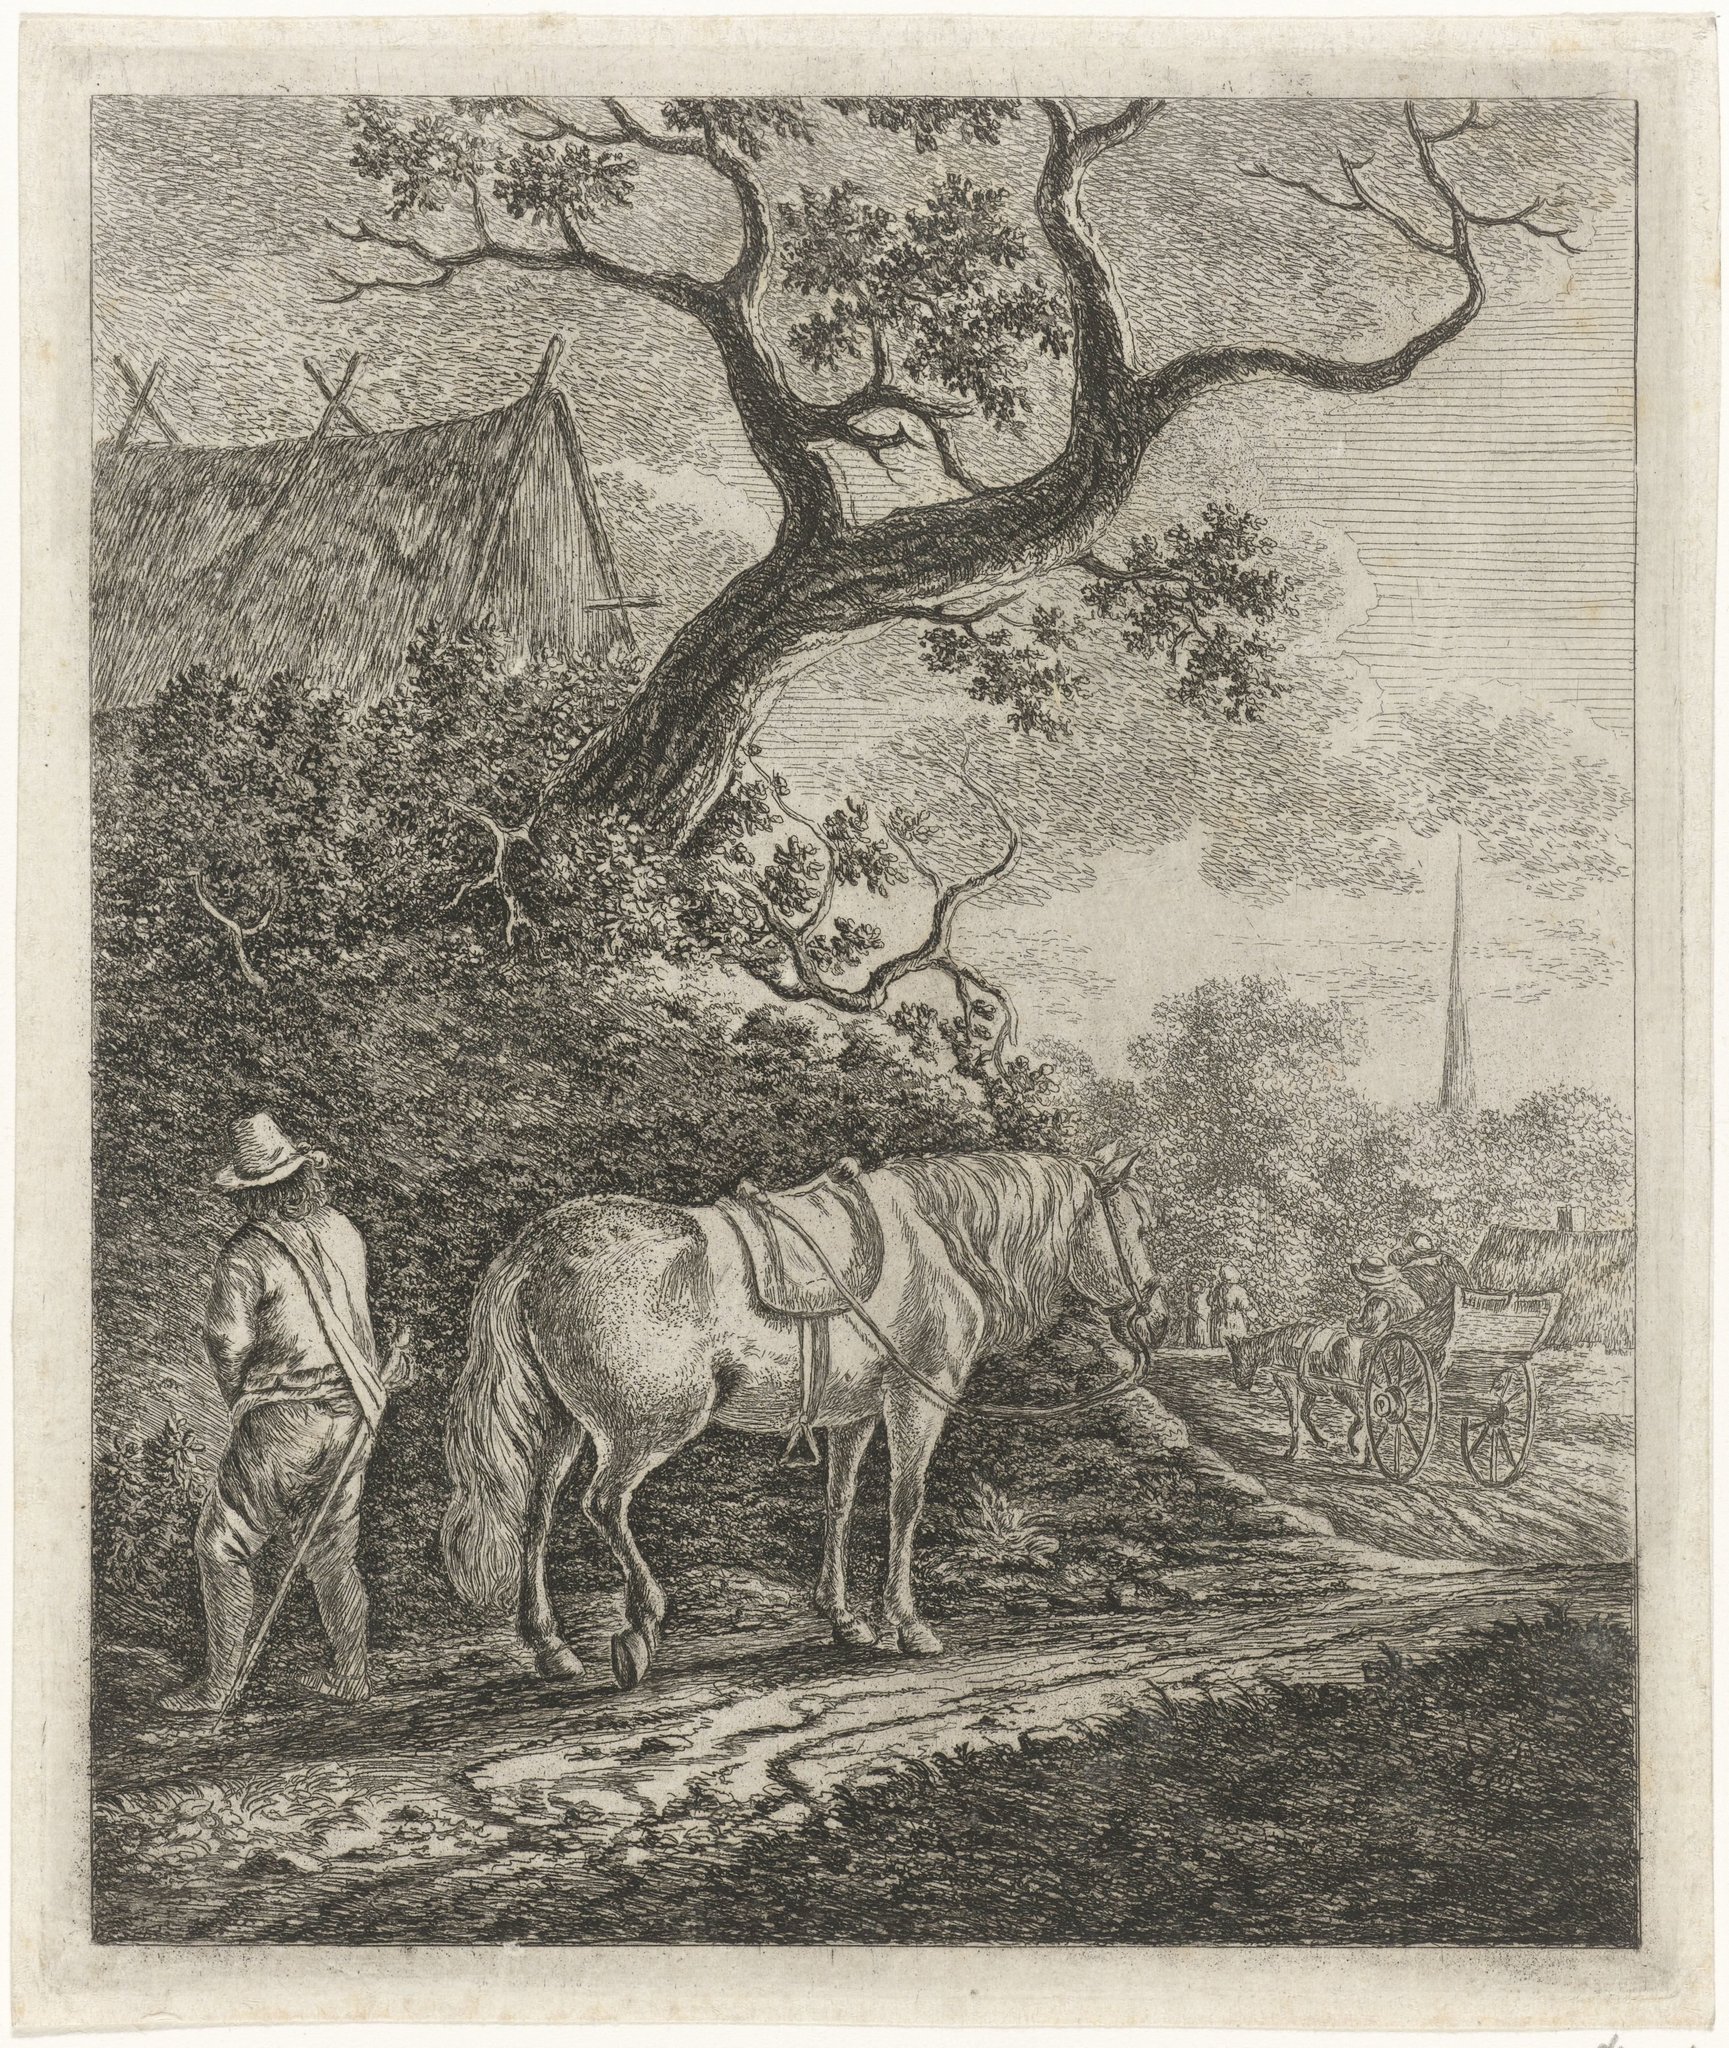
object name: print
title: Paard op landweg met waterende man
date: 1752-1783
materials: paper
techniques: etching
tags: horse, urination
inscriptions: collector's mark: Lugt 2228